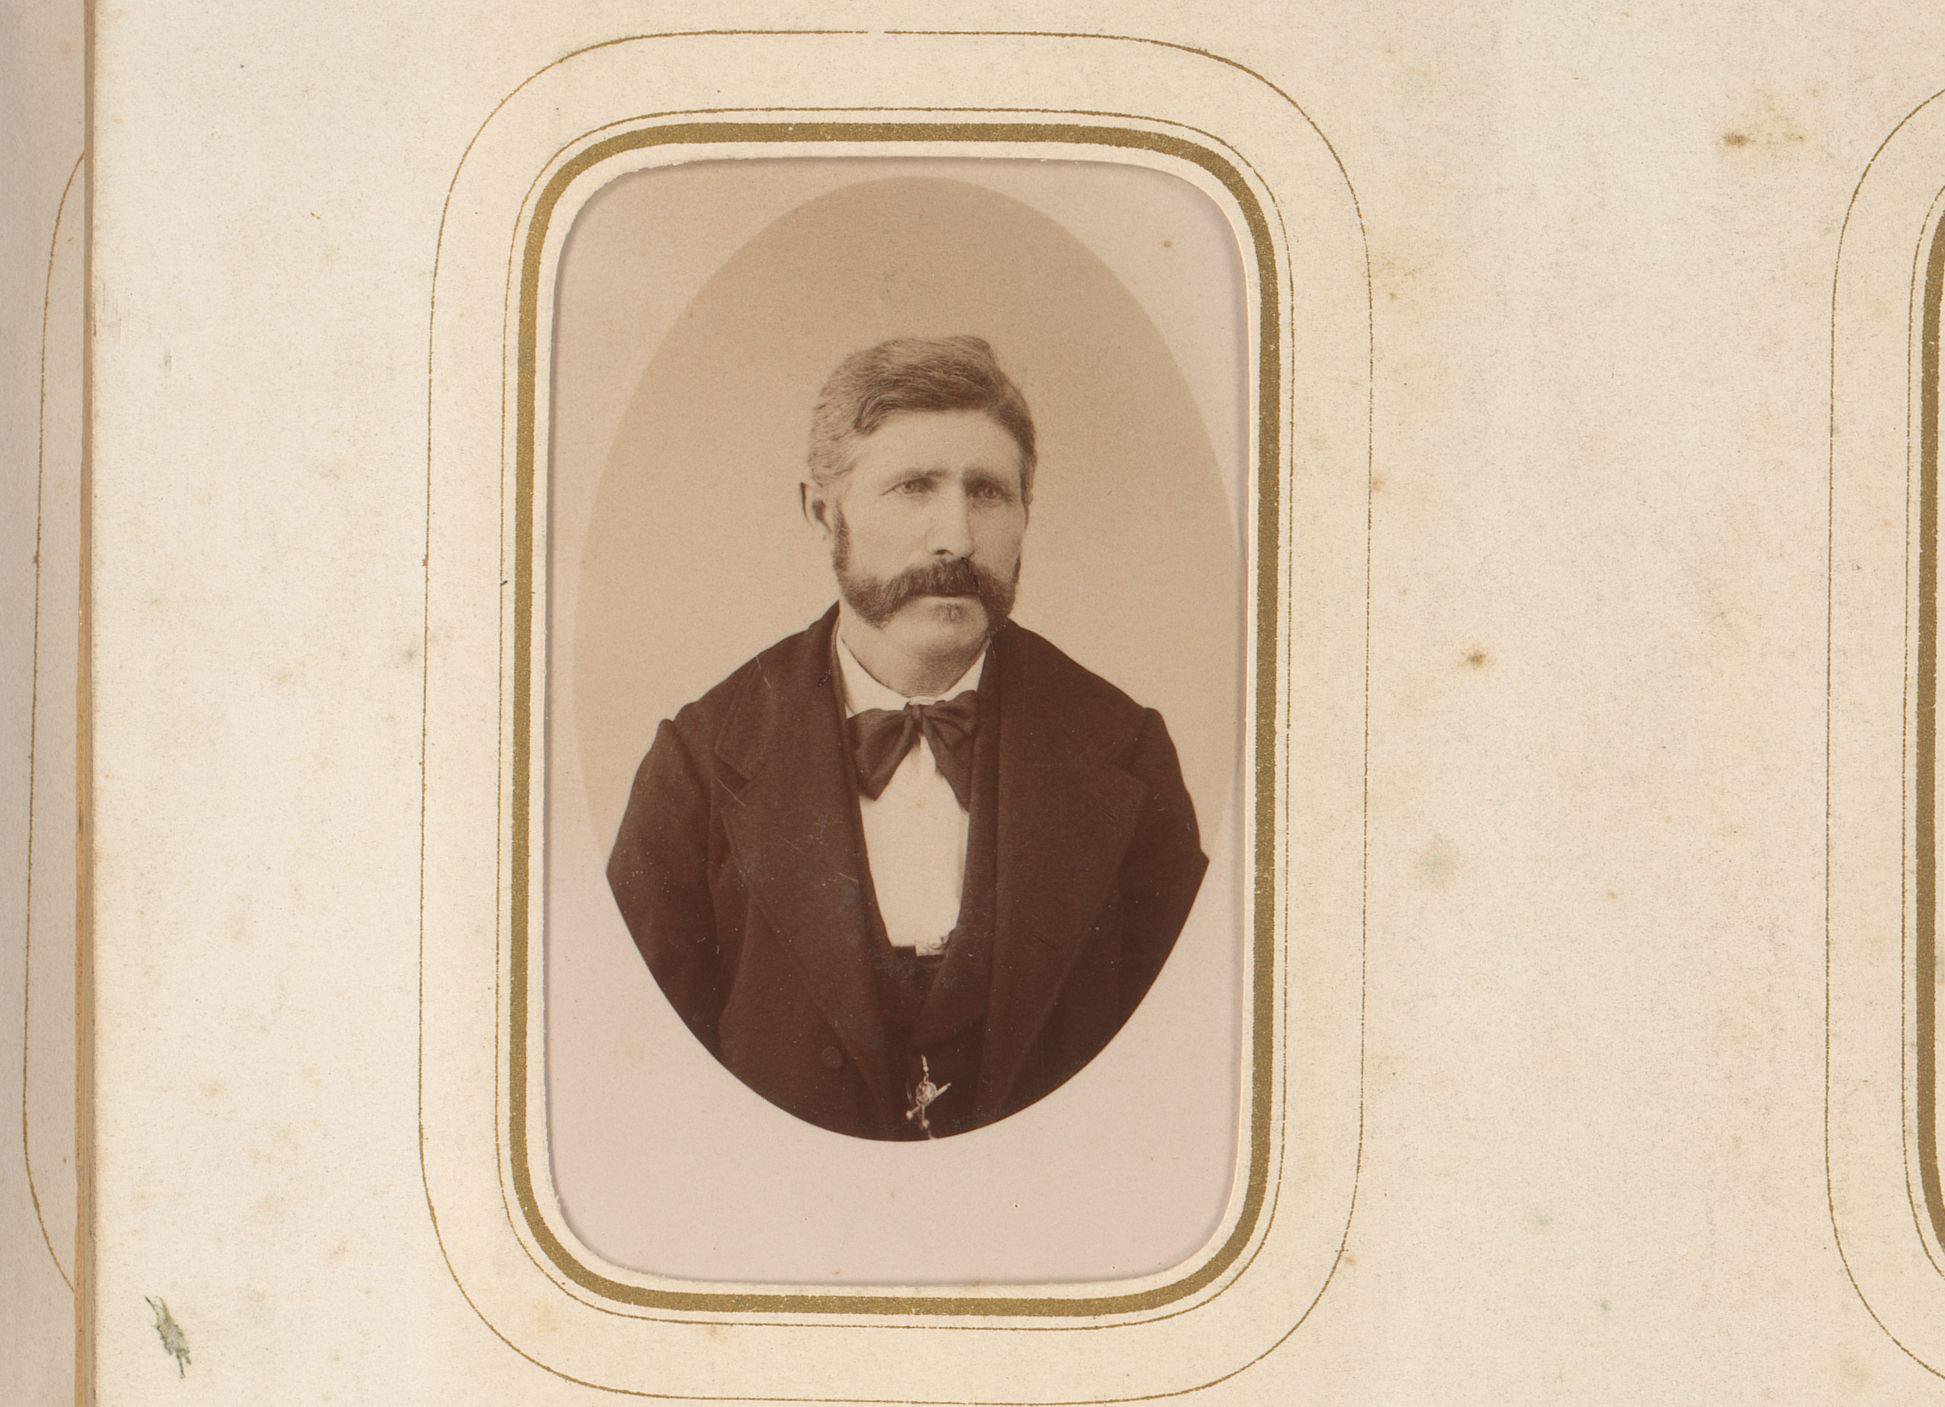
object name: semi enamel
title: Portret van een man met snor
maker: Anonymous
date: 1880-1900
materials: cardboard, celluloid, photographic support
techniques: albumen print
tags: moustache, historical persons